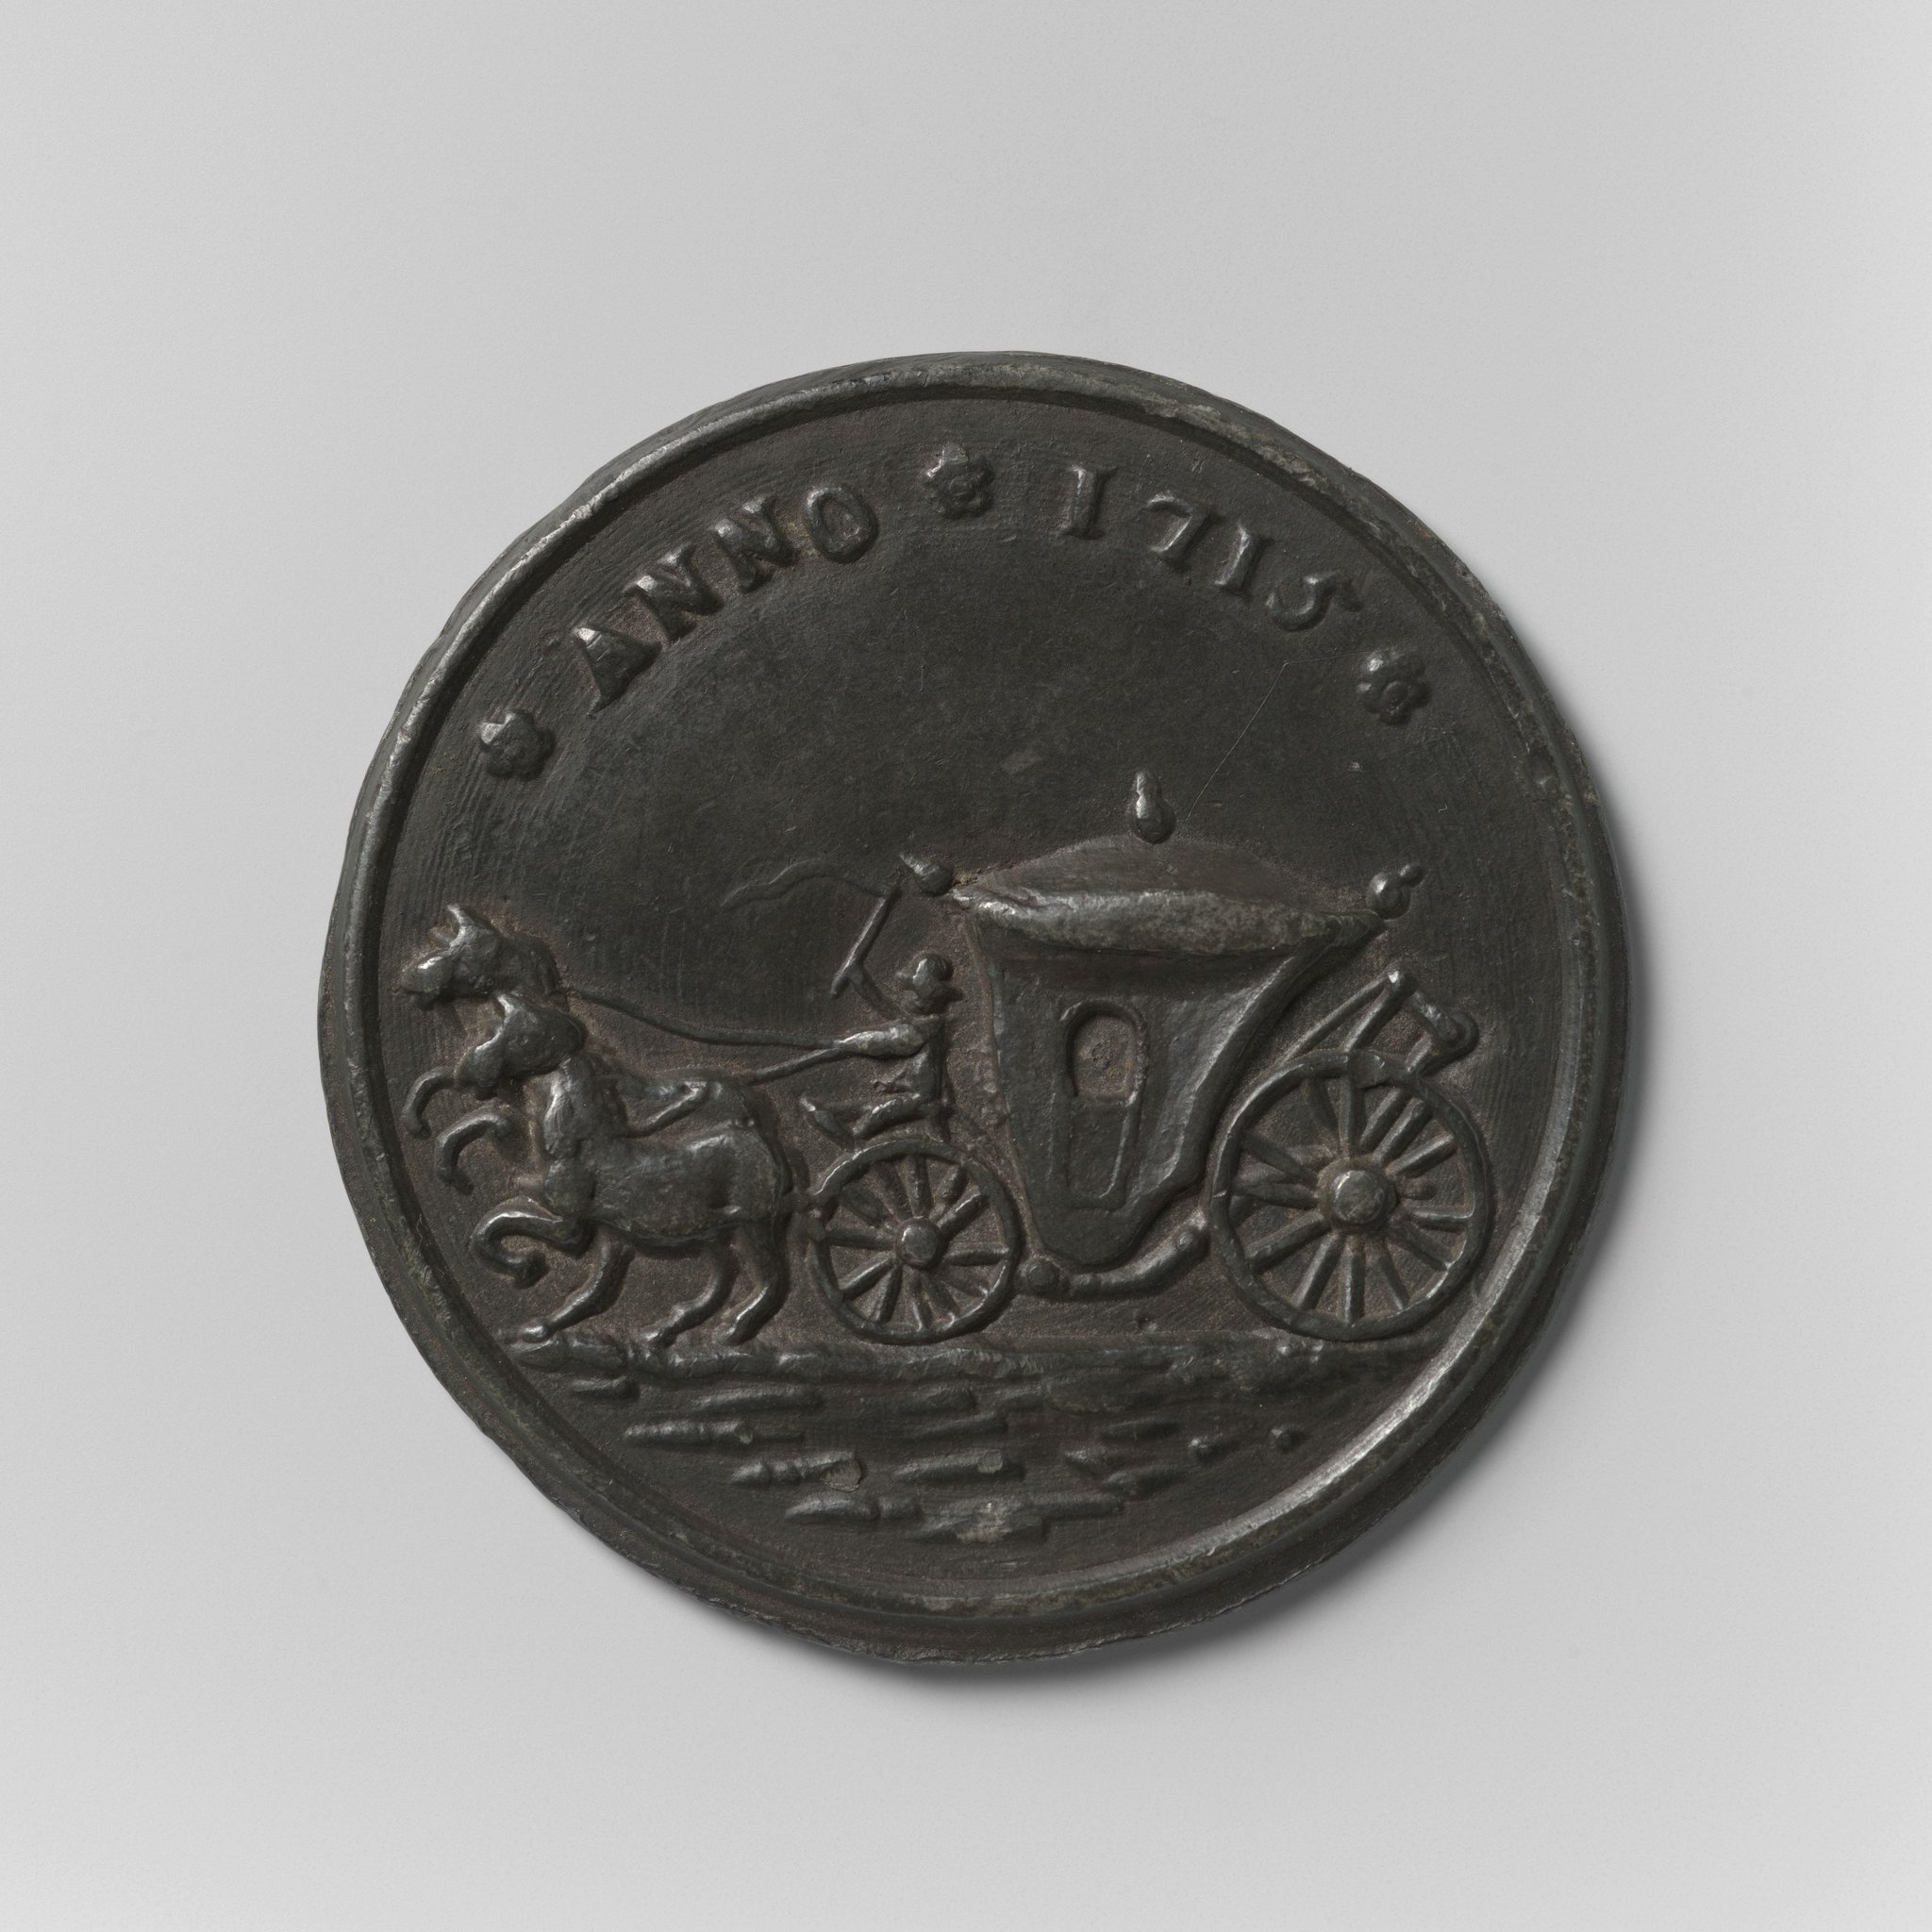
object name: medal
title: Begrafenispenning van het Huurkoetsiersgilde te 's-Gravenhage, 1715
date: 1709-1781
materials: tin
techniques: casting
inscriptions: inscription: ‘BEGRAFENIS / PENNING / VAN / COETSIERS / BUSSE / N°’, inscription: ‘(roos) ANNO (roos) 1715 (roos)’, inscription: ‘61’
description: Forse gegoten tinnen penning, op de voorzijde een koets met koetsier en tweespan in landschap, op de keerzijde zes regels tekst, met inscriptie nummer 61